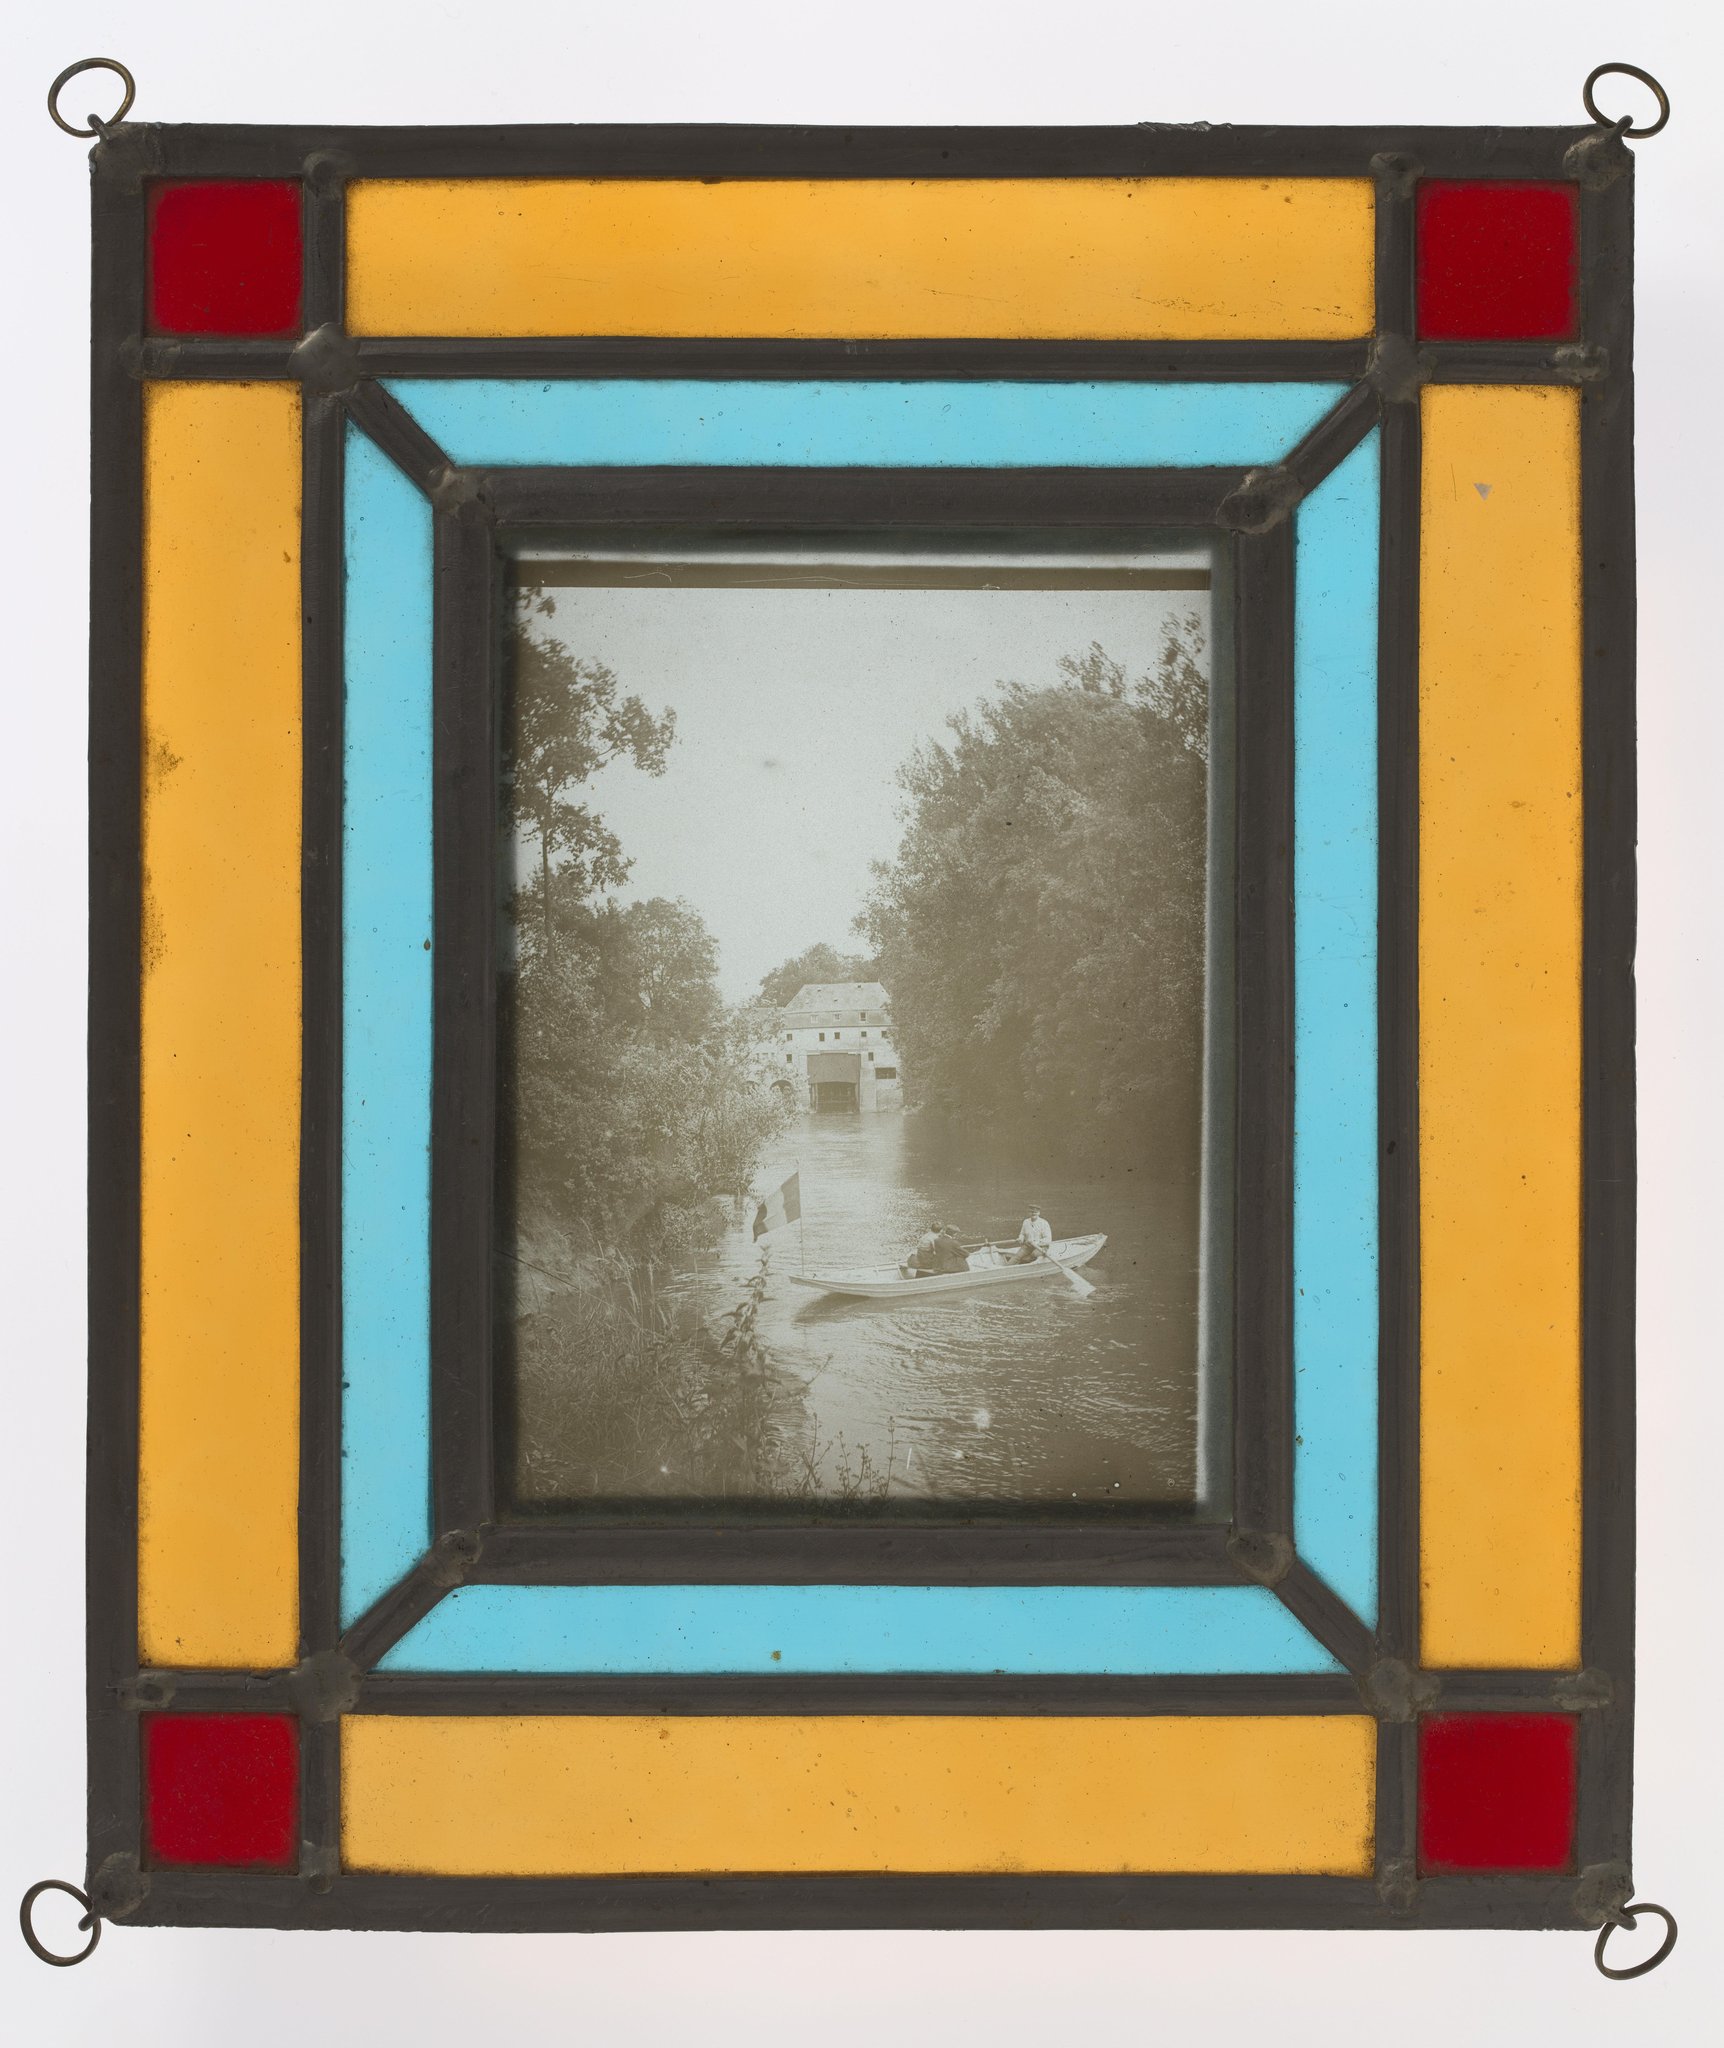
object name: sheet glass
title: Riviergezicht met roeiboot en watermolen, in omraming van glas in lood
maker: Anonymous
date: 1880-1910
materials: glass, lead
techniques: leading, collodion process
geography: france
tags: rowing facing backward, pulling, watermill in landscape, france